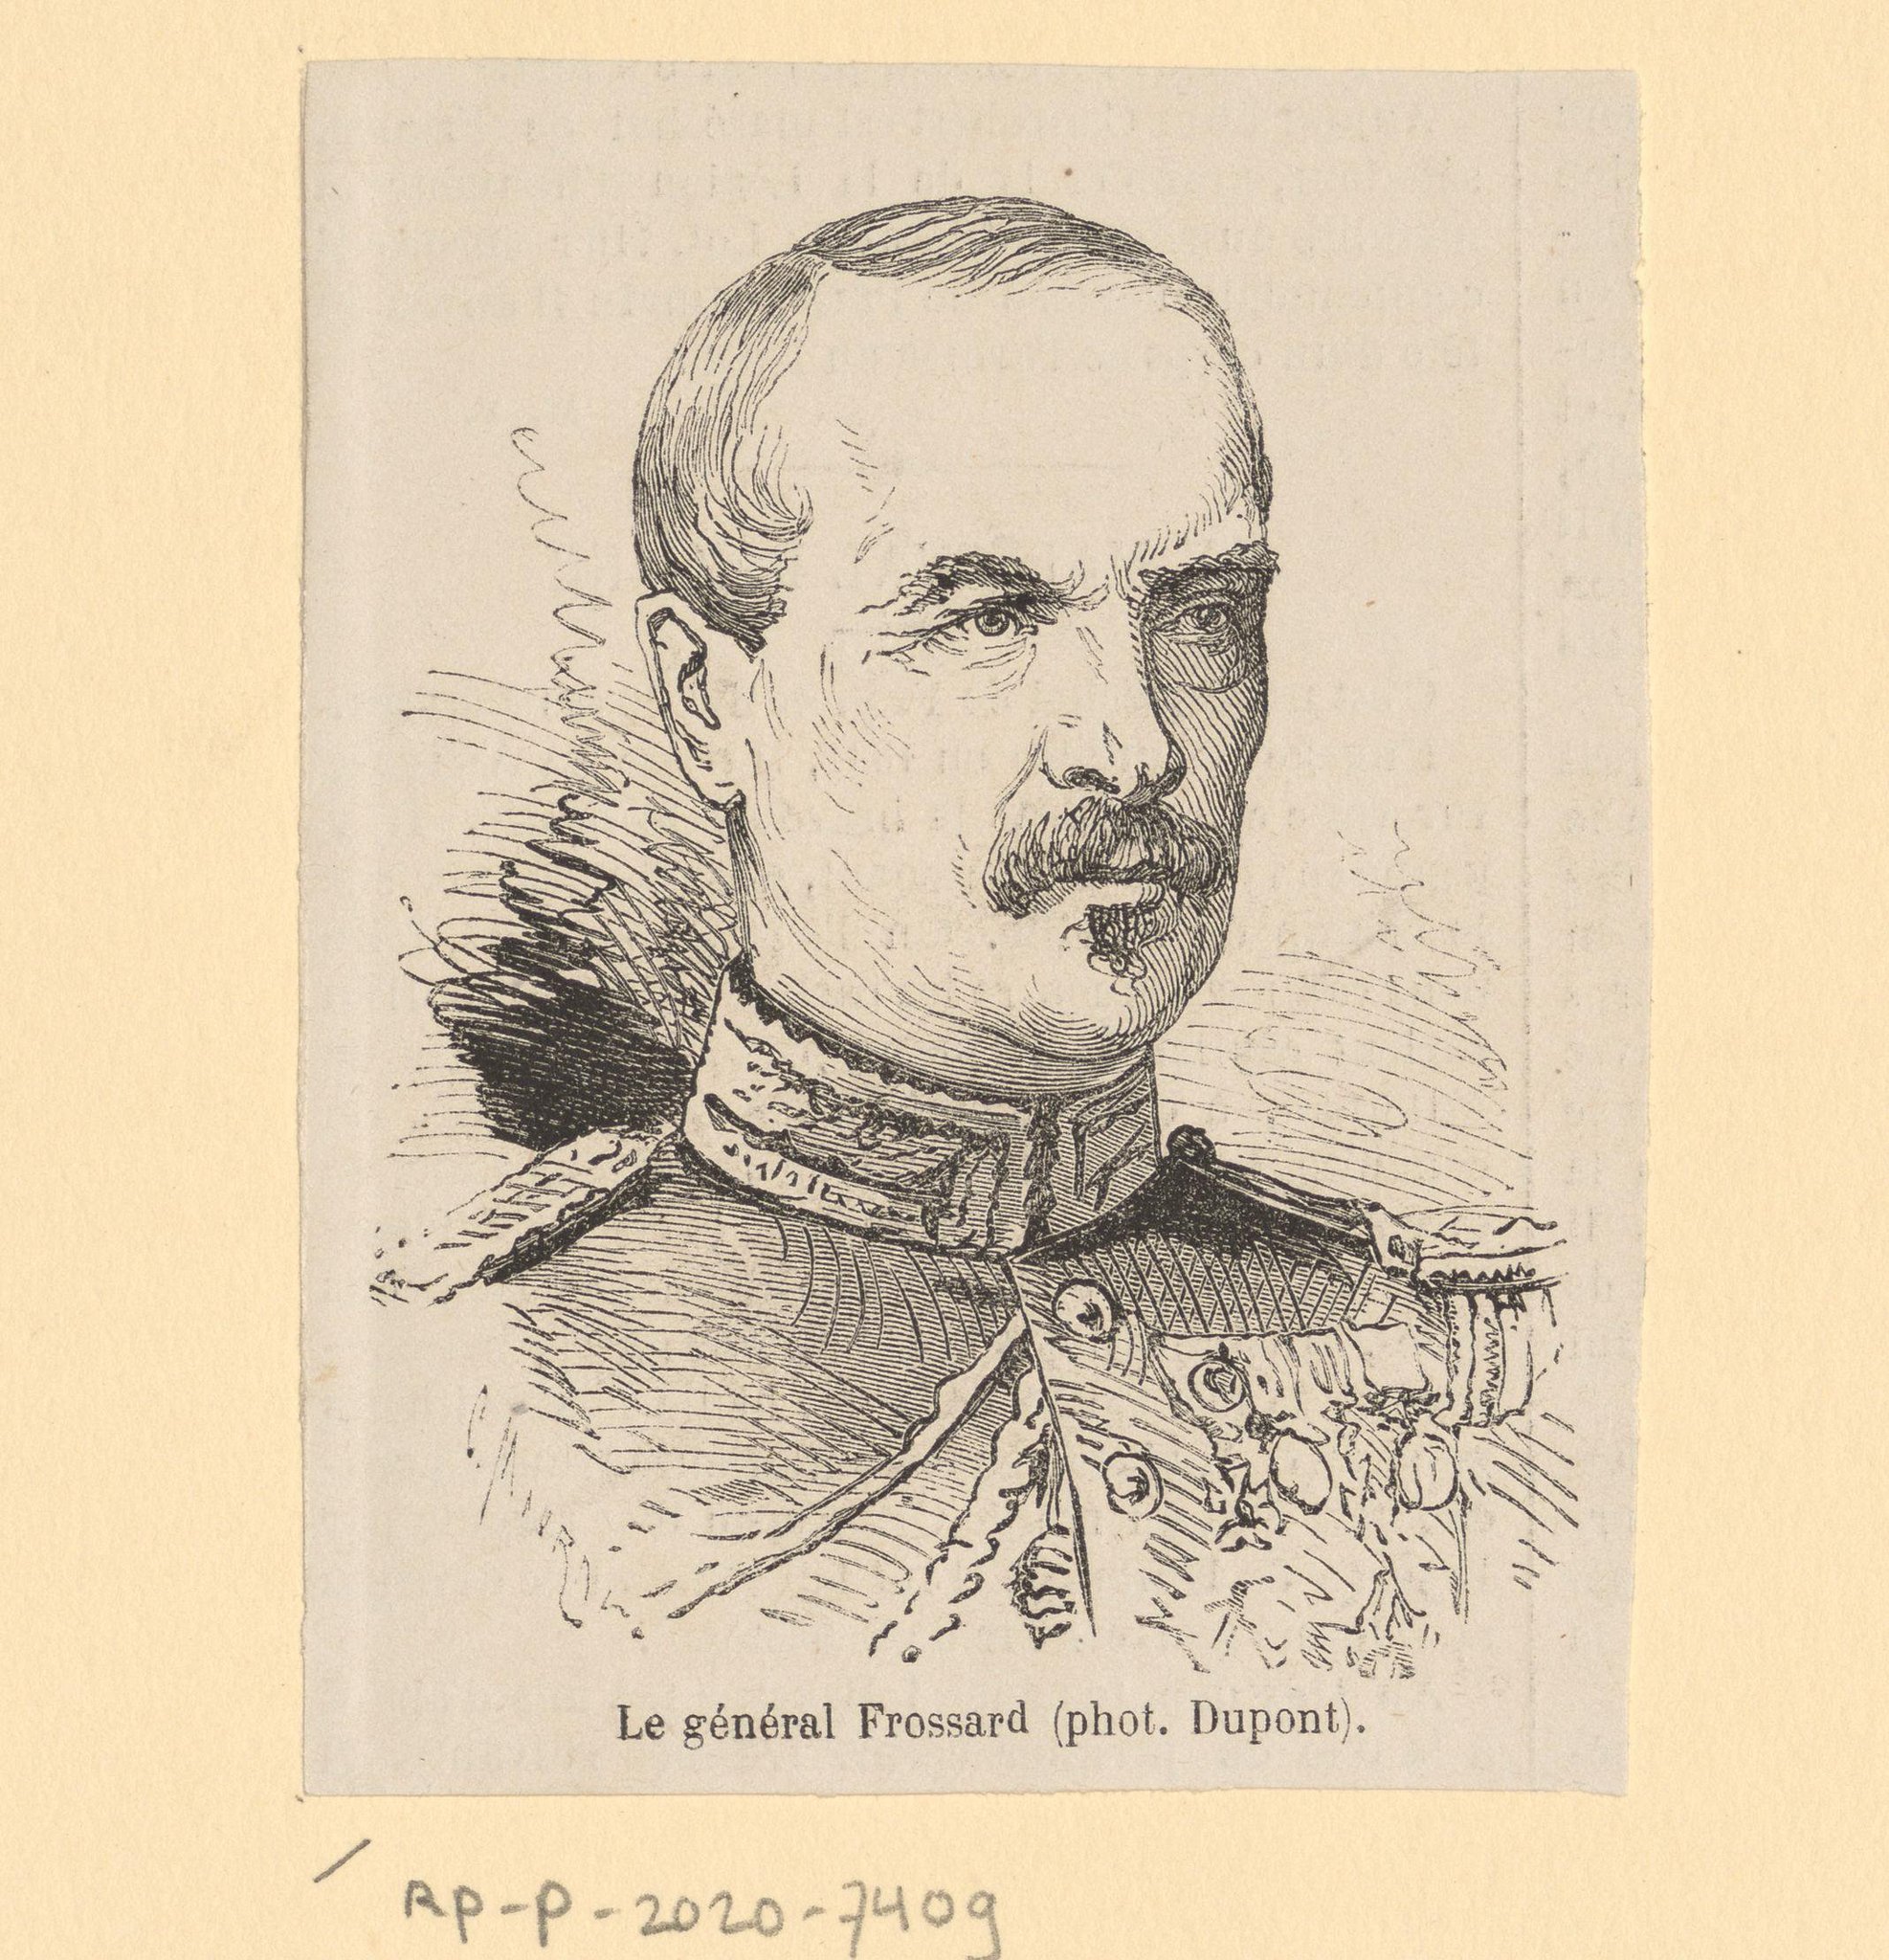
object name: print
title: Portret van Charles Auguste Frossard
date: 1870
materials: paper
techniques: letterpress printing, engraving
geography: paris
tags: commander-in-chief, general, marshal, historical persons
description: Prent uit: Le Monde Illustré 14 (1870), nr. 693, 23 juli 1870.